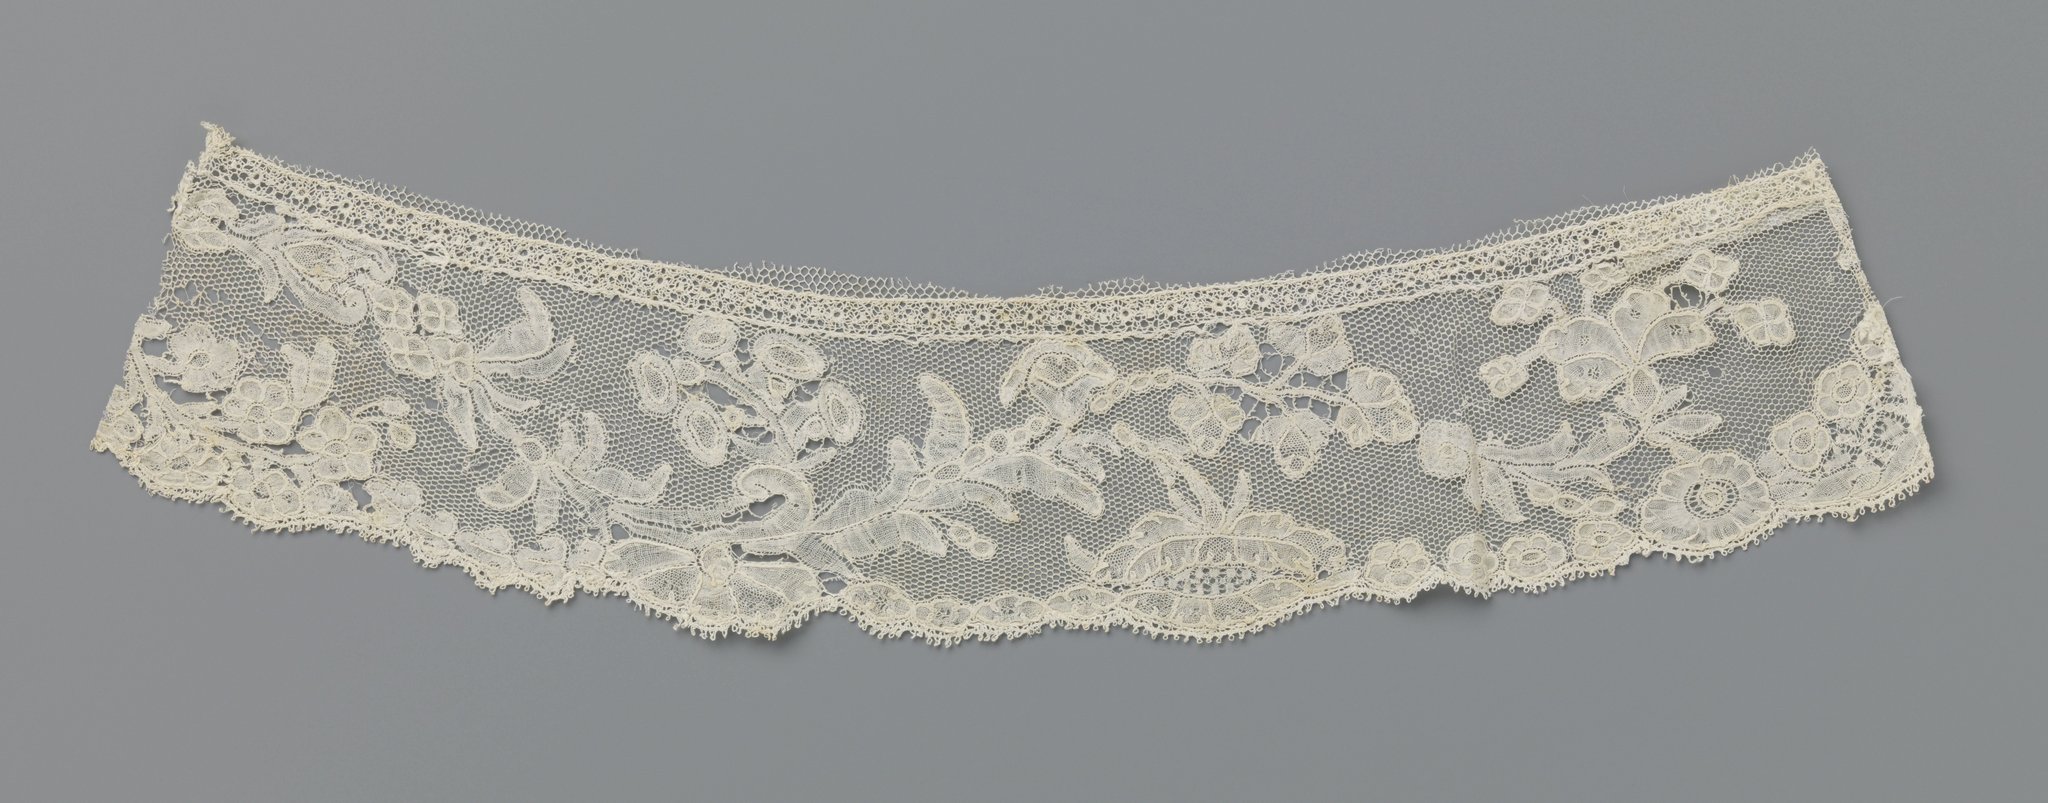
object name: strip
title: Strook kloskant met parelsnoer in samengestelde rank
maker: Anonymous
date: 1740-1760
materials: linen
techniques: lace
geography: brussels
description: Strook naturelkleurige Brusselse kloskant. Het patroon bestaat uit een golvende rank, die samengesteld is uit allerlei soorten blaadjes, een hartvormige bloem, een tros met ovale bloemen, een parelsnoer en aan het uiteinde een anjer waaruit klavertjes vier ontspringen. De rank oversnijdt deels het patroon langs de onderzijde van de strook, dat bestaat uit onder andere een tak vergeet-mij-nietjes, een ovaalvormig cartouche en aaneengeschakelde blaadjes en rozetjebloempjes. De motieven zijn met elkaar verbonden door een fijne maasgrond, een drochelgrond. Het volwerk is grotendeels gemaakt in linnenslag met opengewerkte randjes en enkele uitsparingen. Enkele bloemharten en bloemblaadjes en dergelijke zijn gemaakt in netslag. De meeste motieven zijn voorzien van gekloste reliëfcontouren. Als siergrond is in het centrum van de ovale cartouche een sneeuwvlokkengrond toegepast en tussen de trosbloemen gepicoteerde vlechten. De bovenzijde is afgewerkt met een apart geklost bandje, waaraan fragmentjes vastzitten van een zeshoekige maasgrond. De onregelmatig geschulpte onderzijde komt voort uit het randpatroon en is afgewerkt met picots.